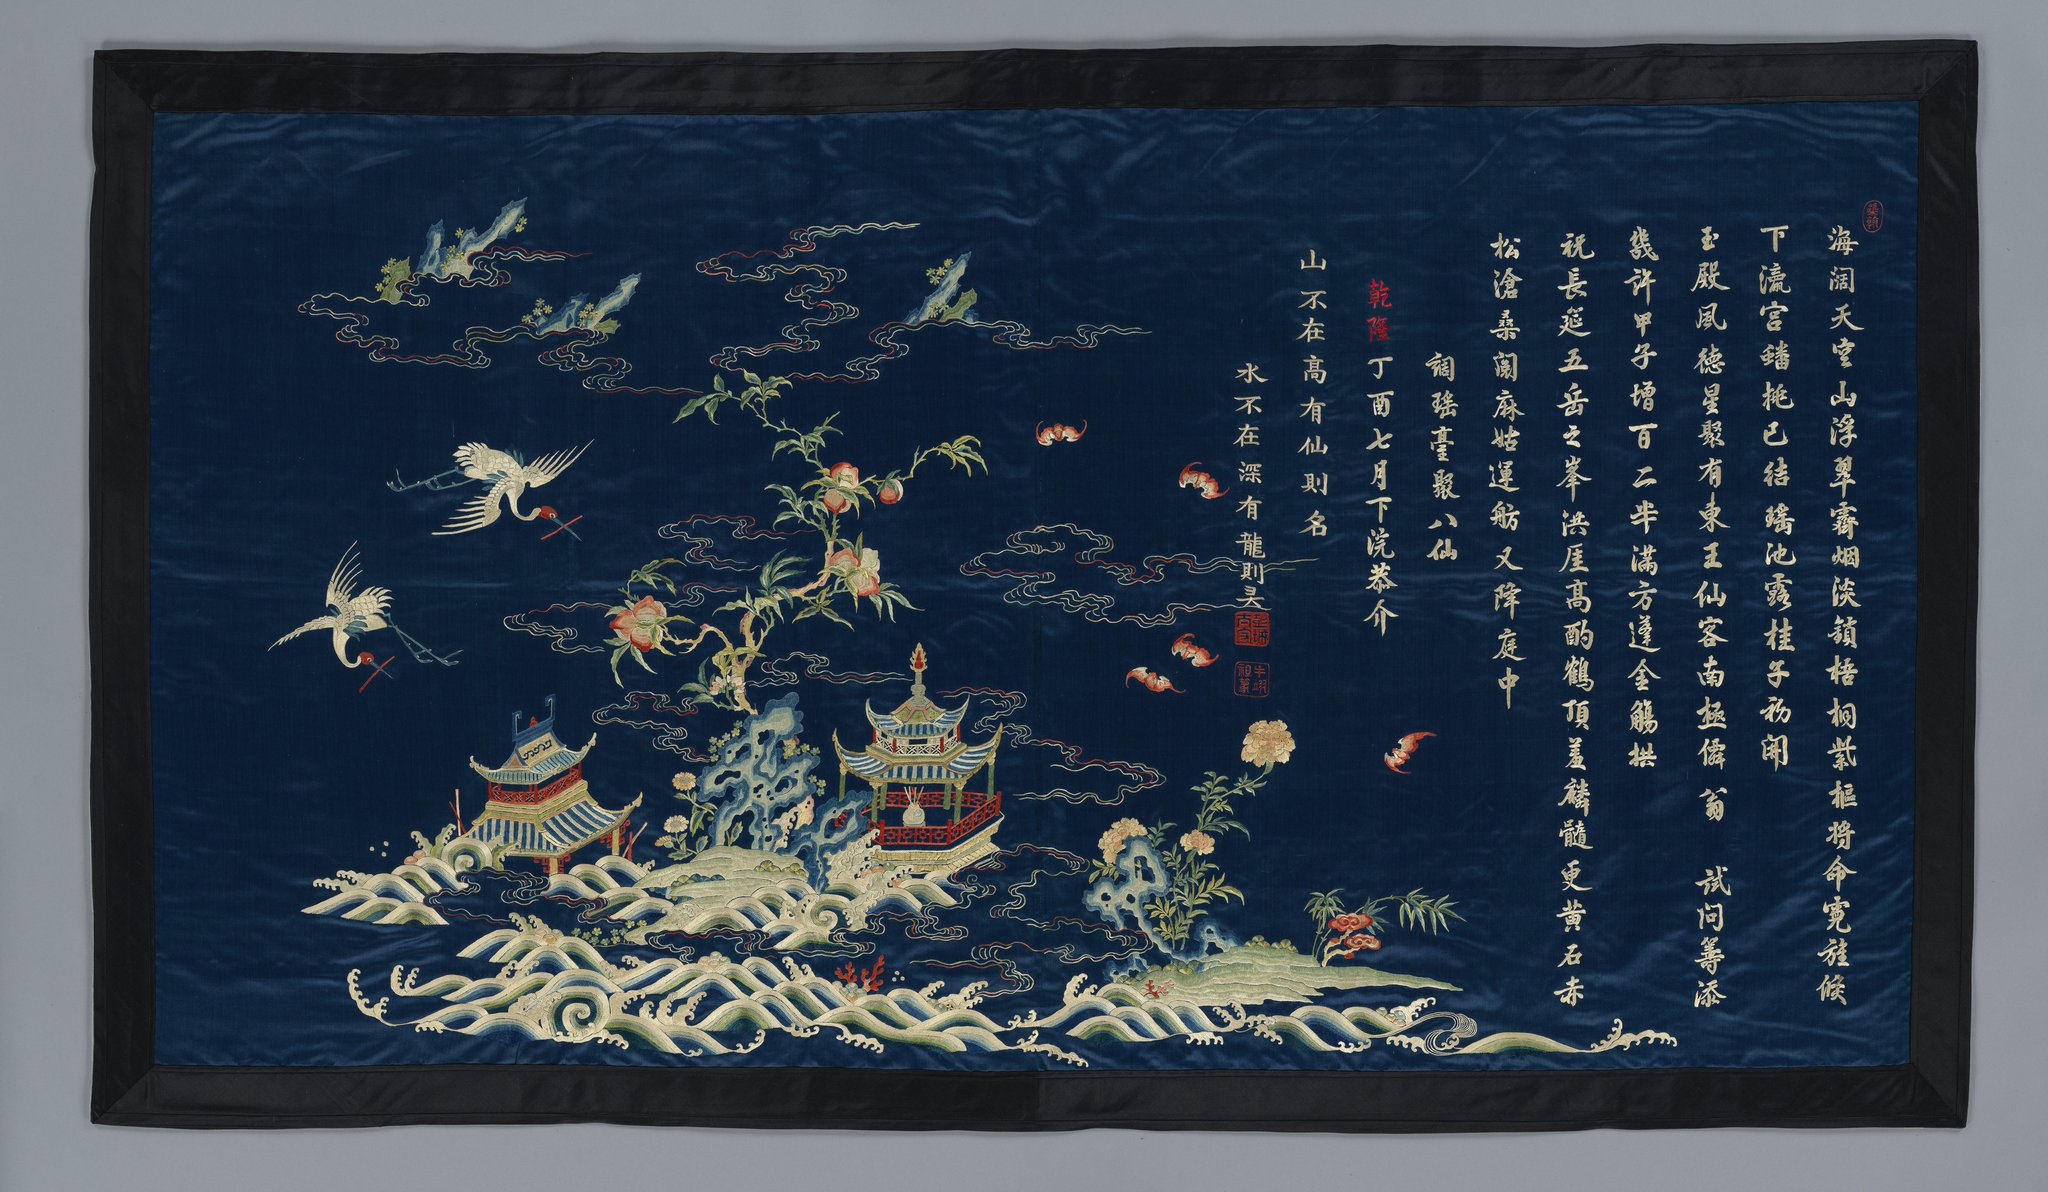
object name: panel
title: Panel with cranes over an immortal land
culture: chinese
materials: silk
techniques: embroidery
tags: cranes